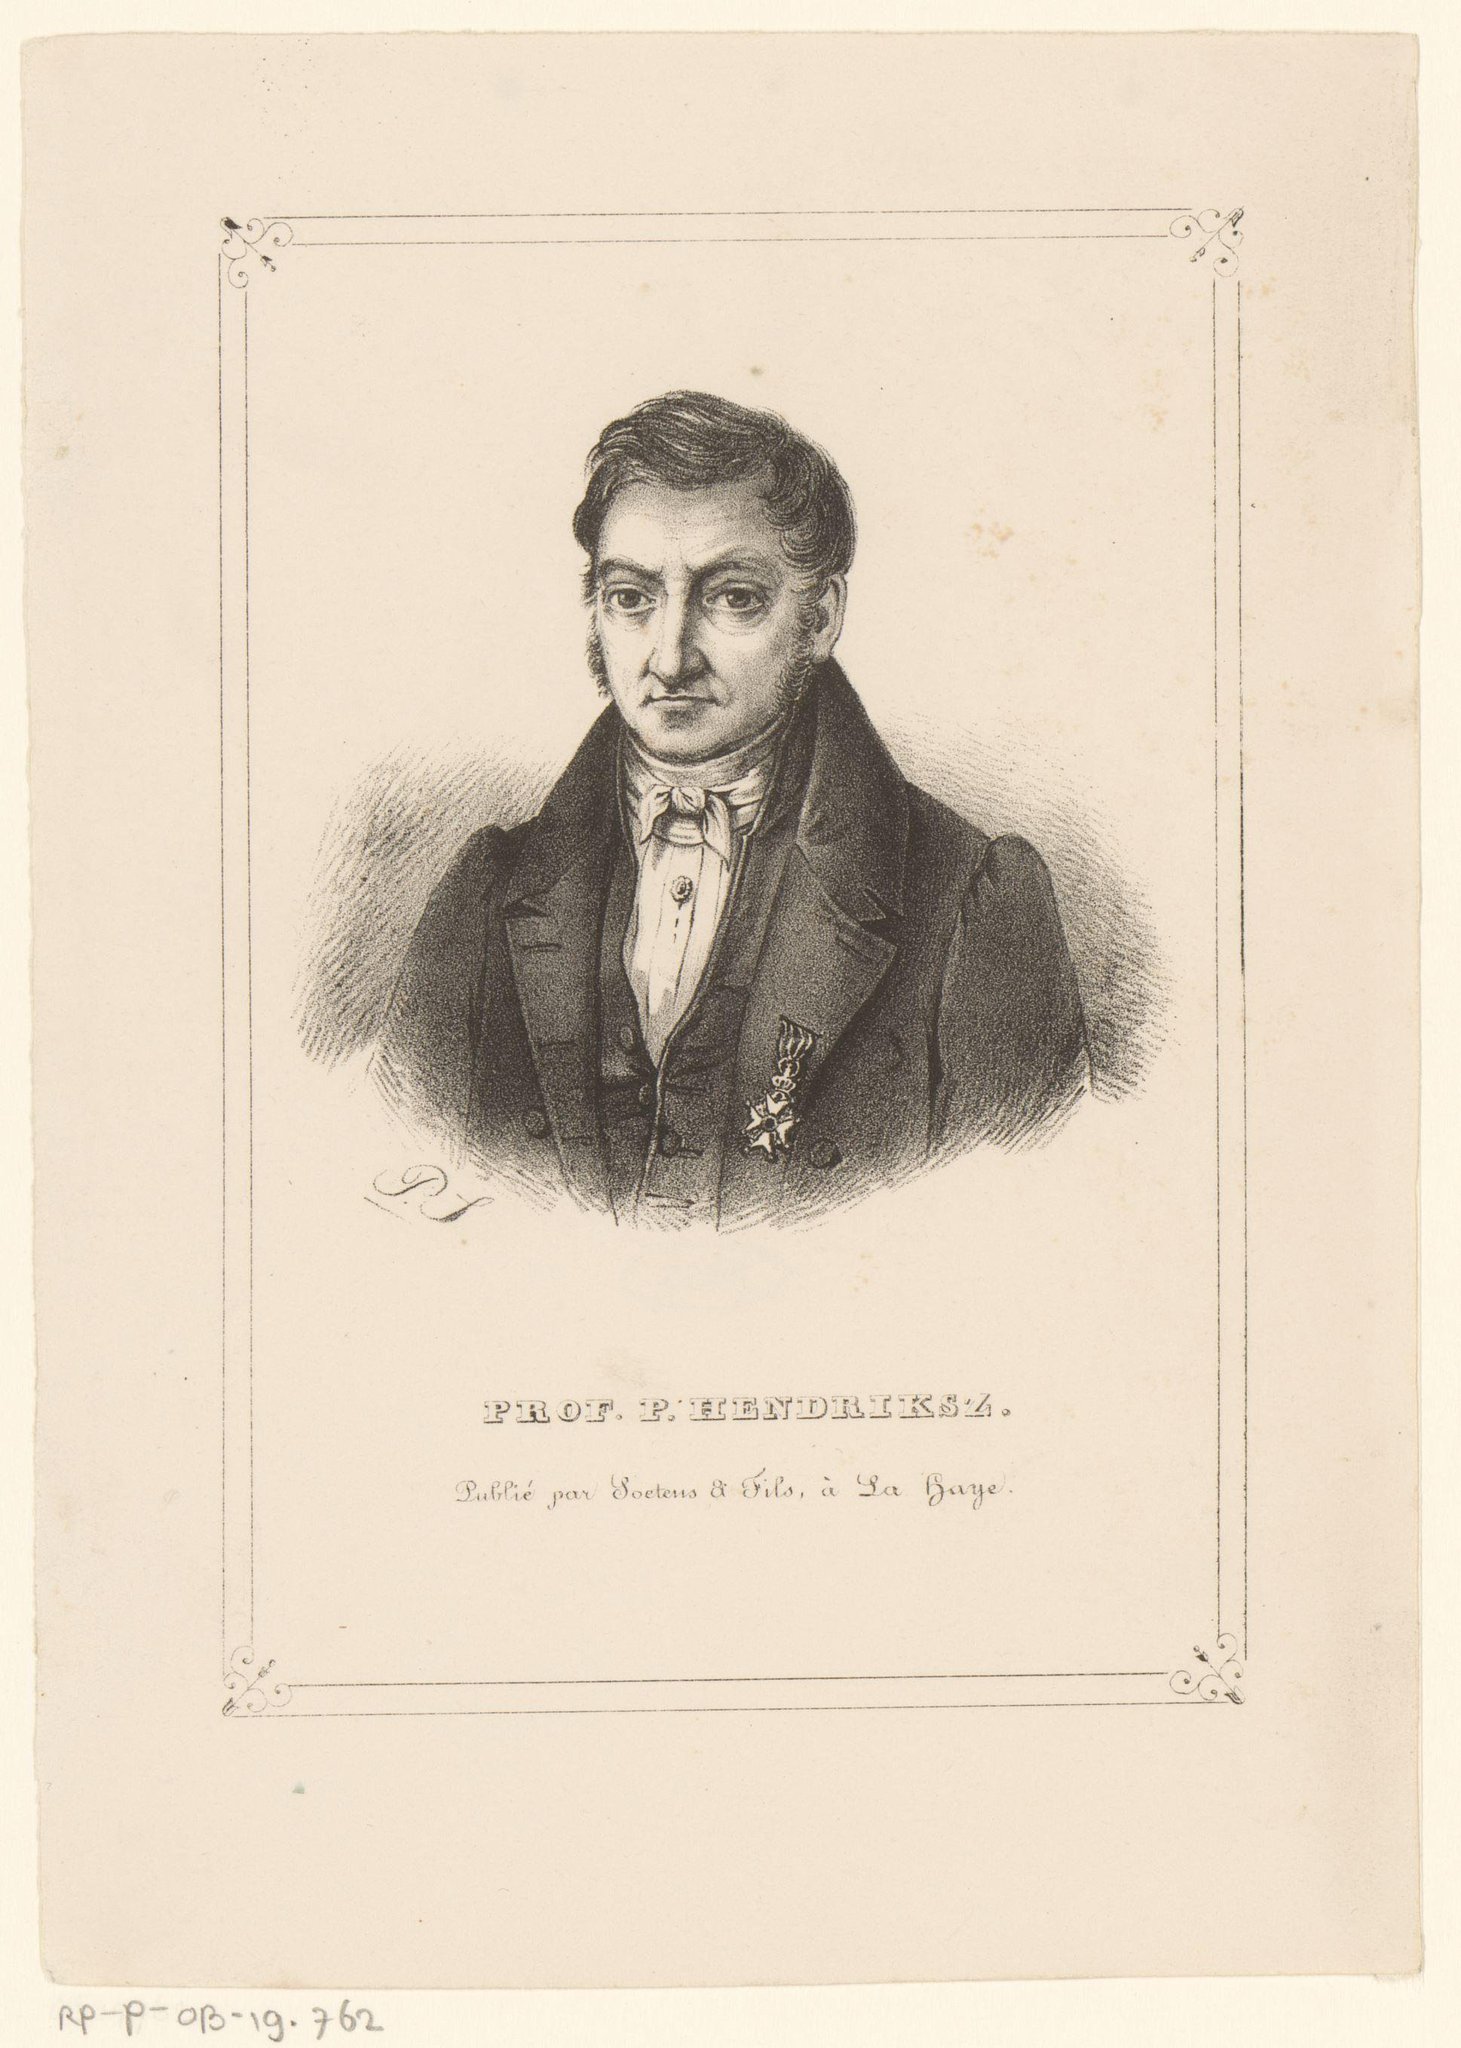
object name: print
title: Portret van Pieter Hendriksz.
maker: Anonymous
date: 1837-1840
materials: paper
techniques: lithograph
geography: the hague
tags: voorburg, historical persons (+ (full) bust portrait)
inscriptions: monogram: ‘P.S.’, collector's mark: Lugt 2228